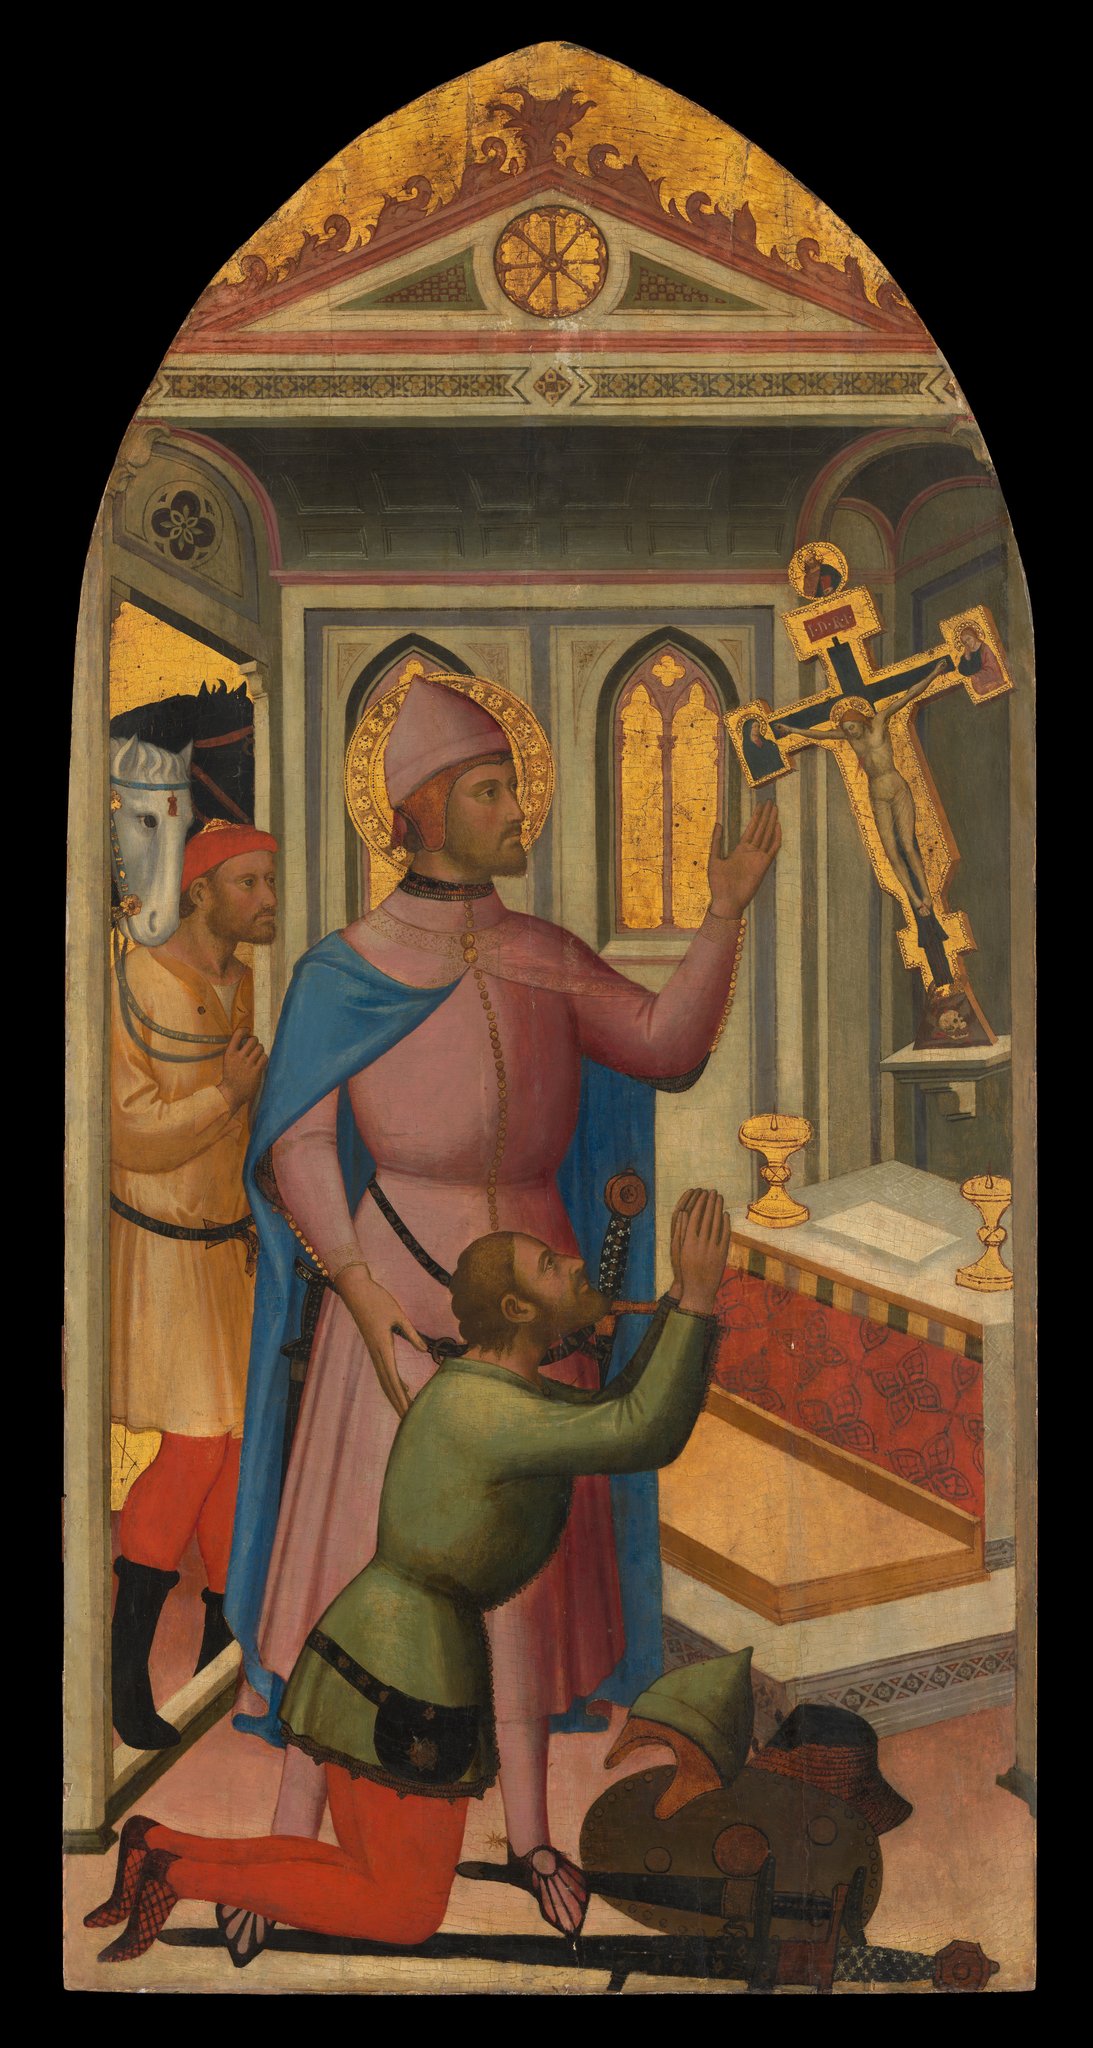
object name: painting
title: An Episode from the Life of Saint Giovanni Gualberto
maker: niccolò di pietro gerini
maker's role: artist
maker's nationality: italian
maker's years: 1368-1415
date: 1368-1415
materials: gold leaf, paint, wood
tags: men,horses,crucifixion,saints